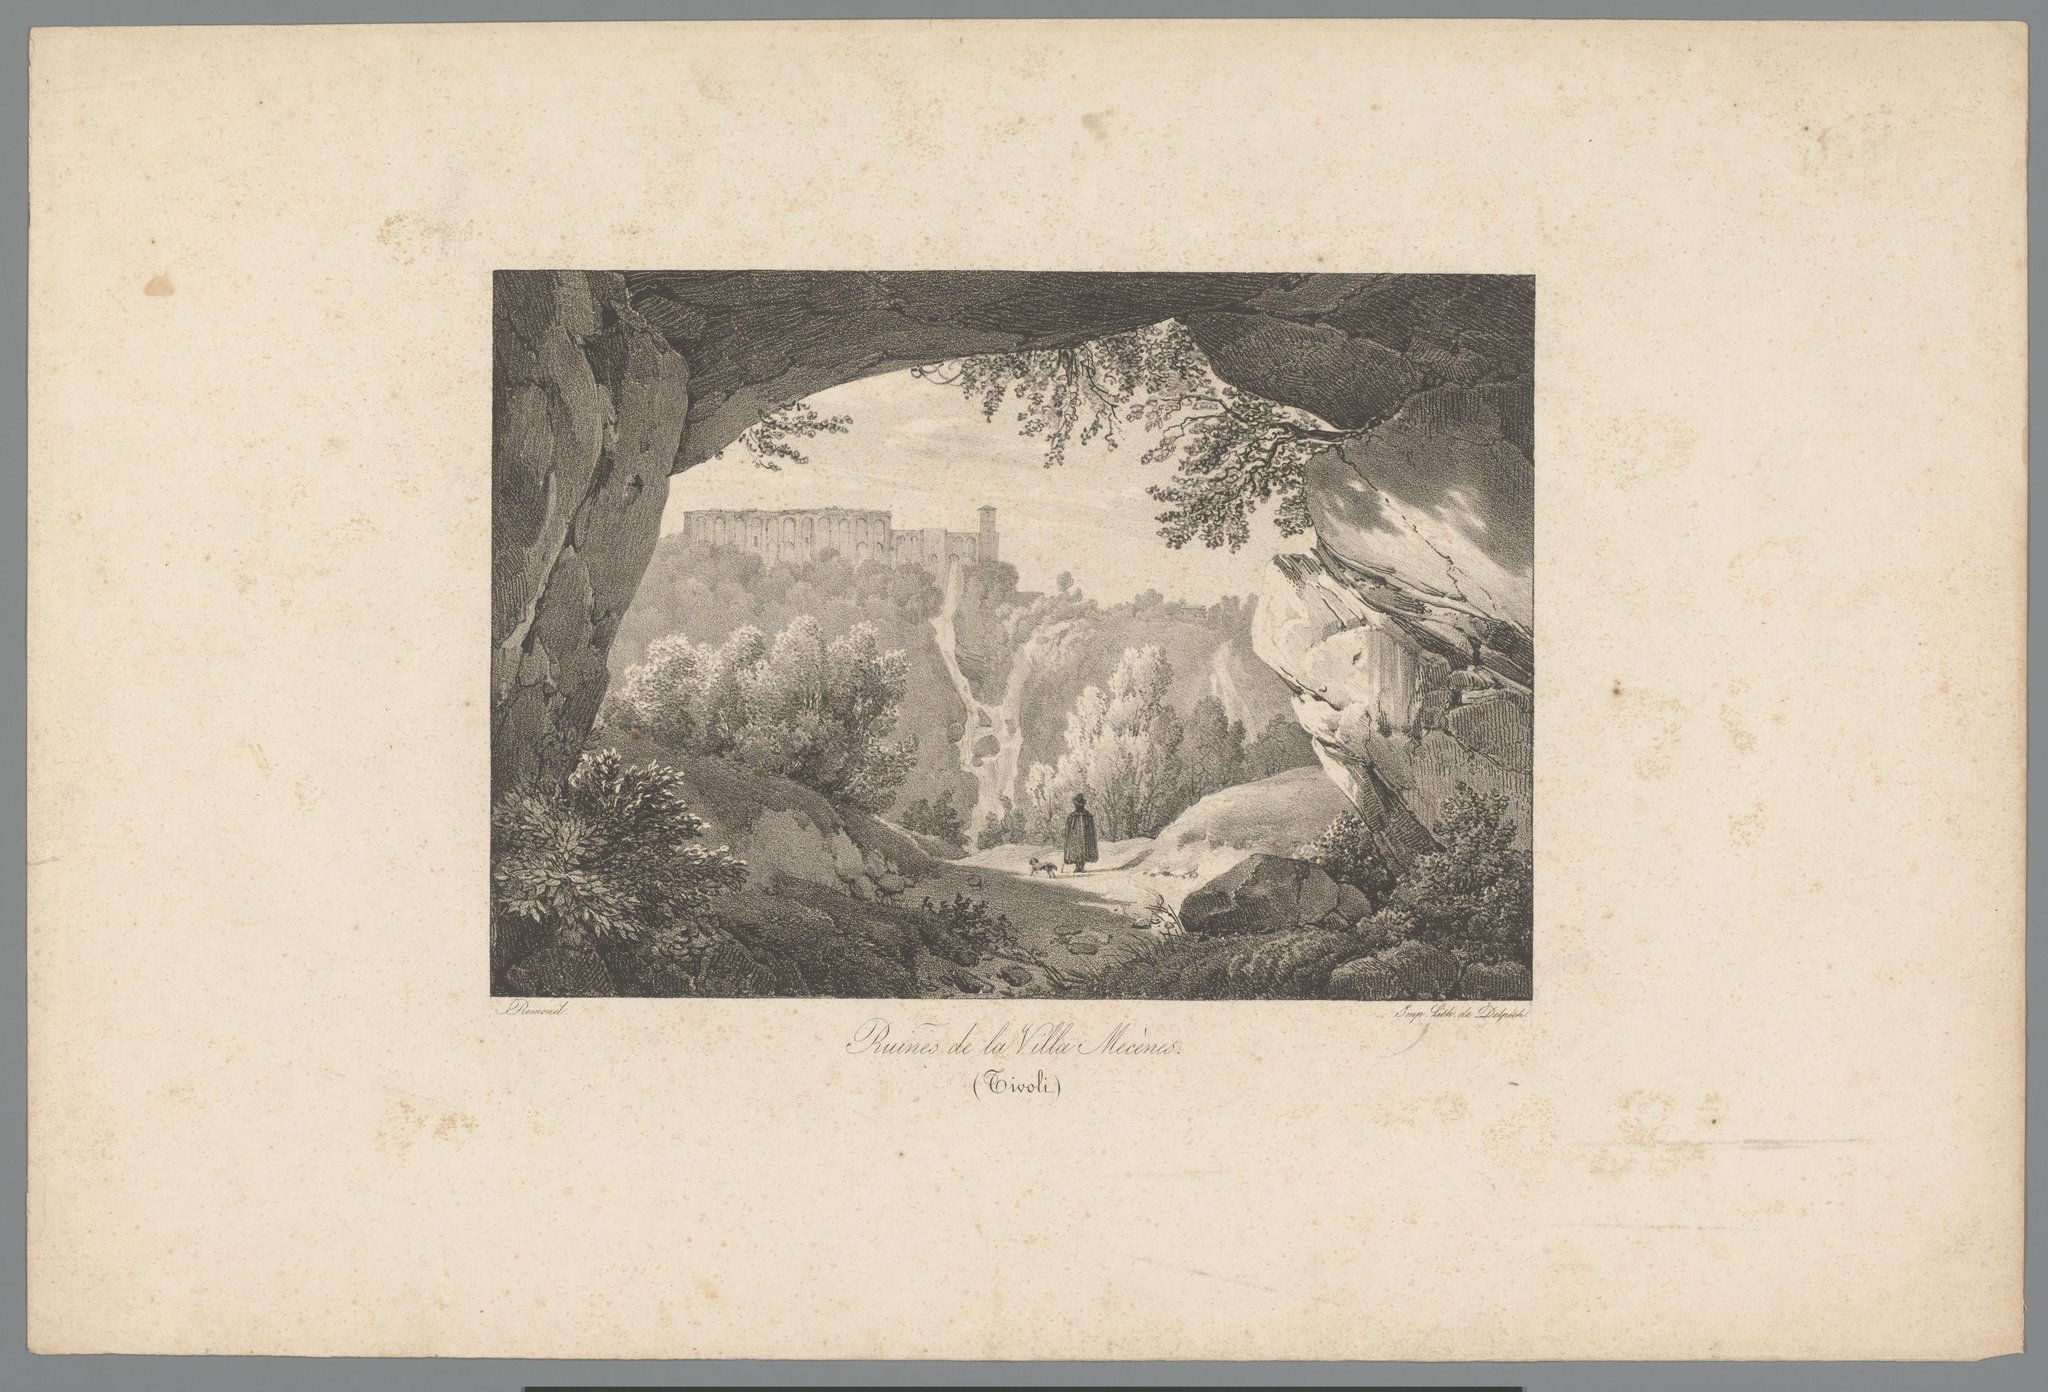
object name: print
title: Ruïnes van de villa van Maecenas bij Tivoli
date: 1827-1828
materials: paper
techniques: lithograph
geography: paris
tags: landscape with ruins, temple of hercules victor, tivoli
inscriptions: collector's mark: Lugt 2228